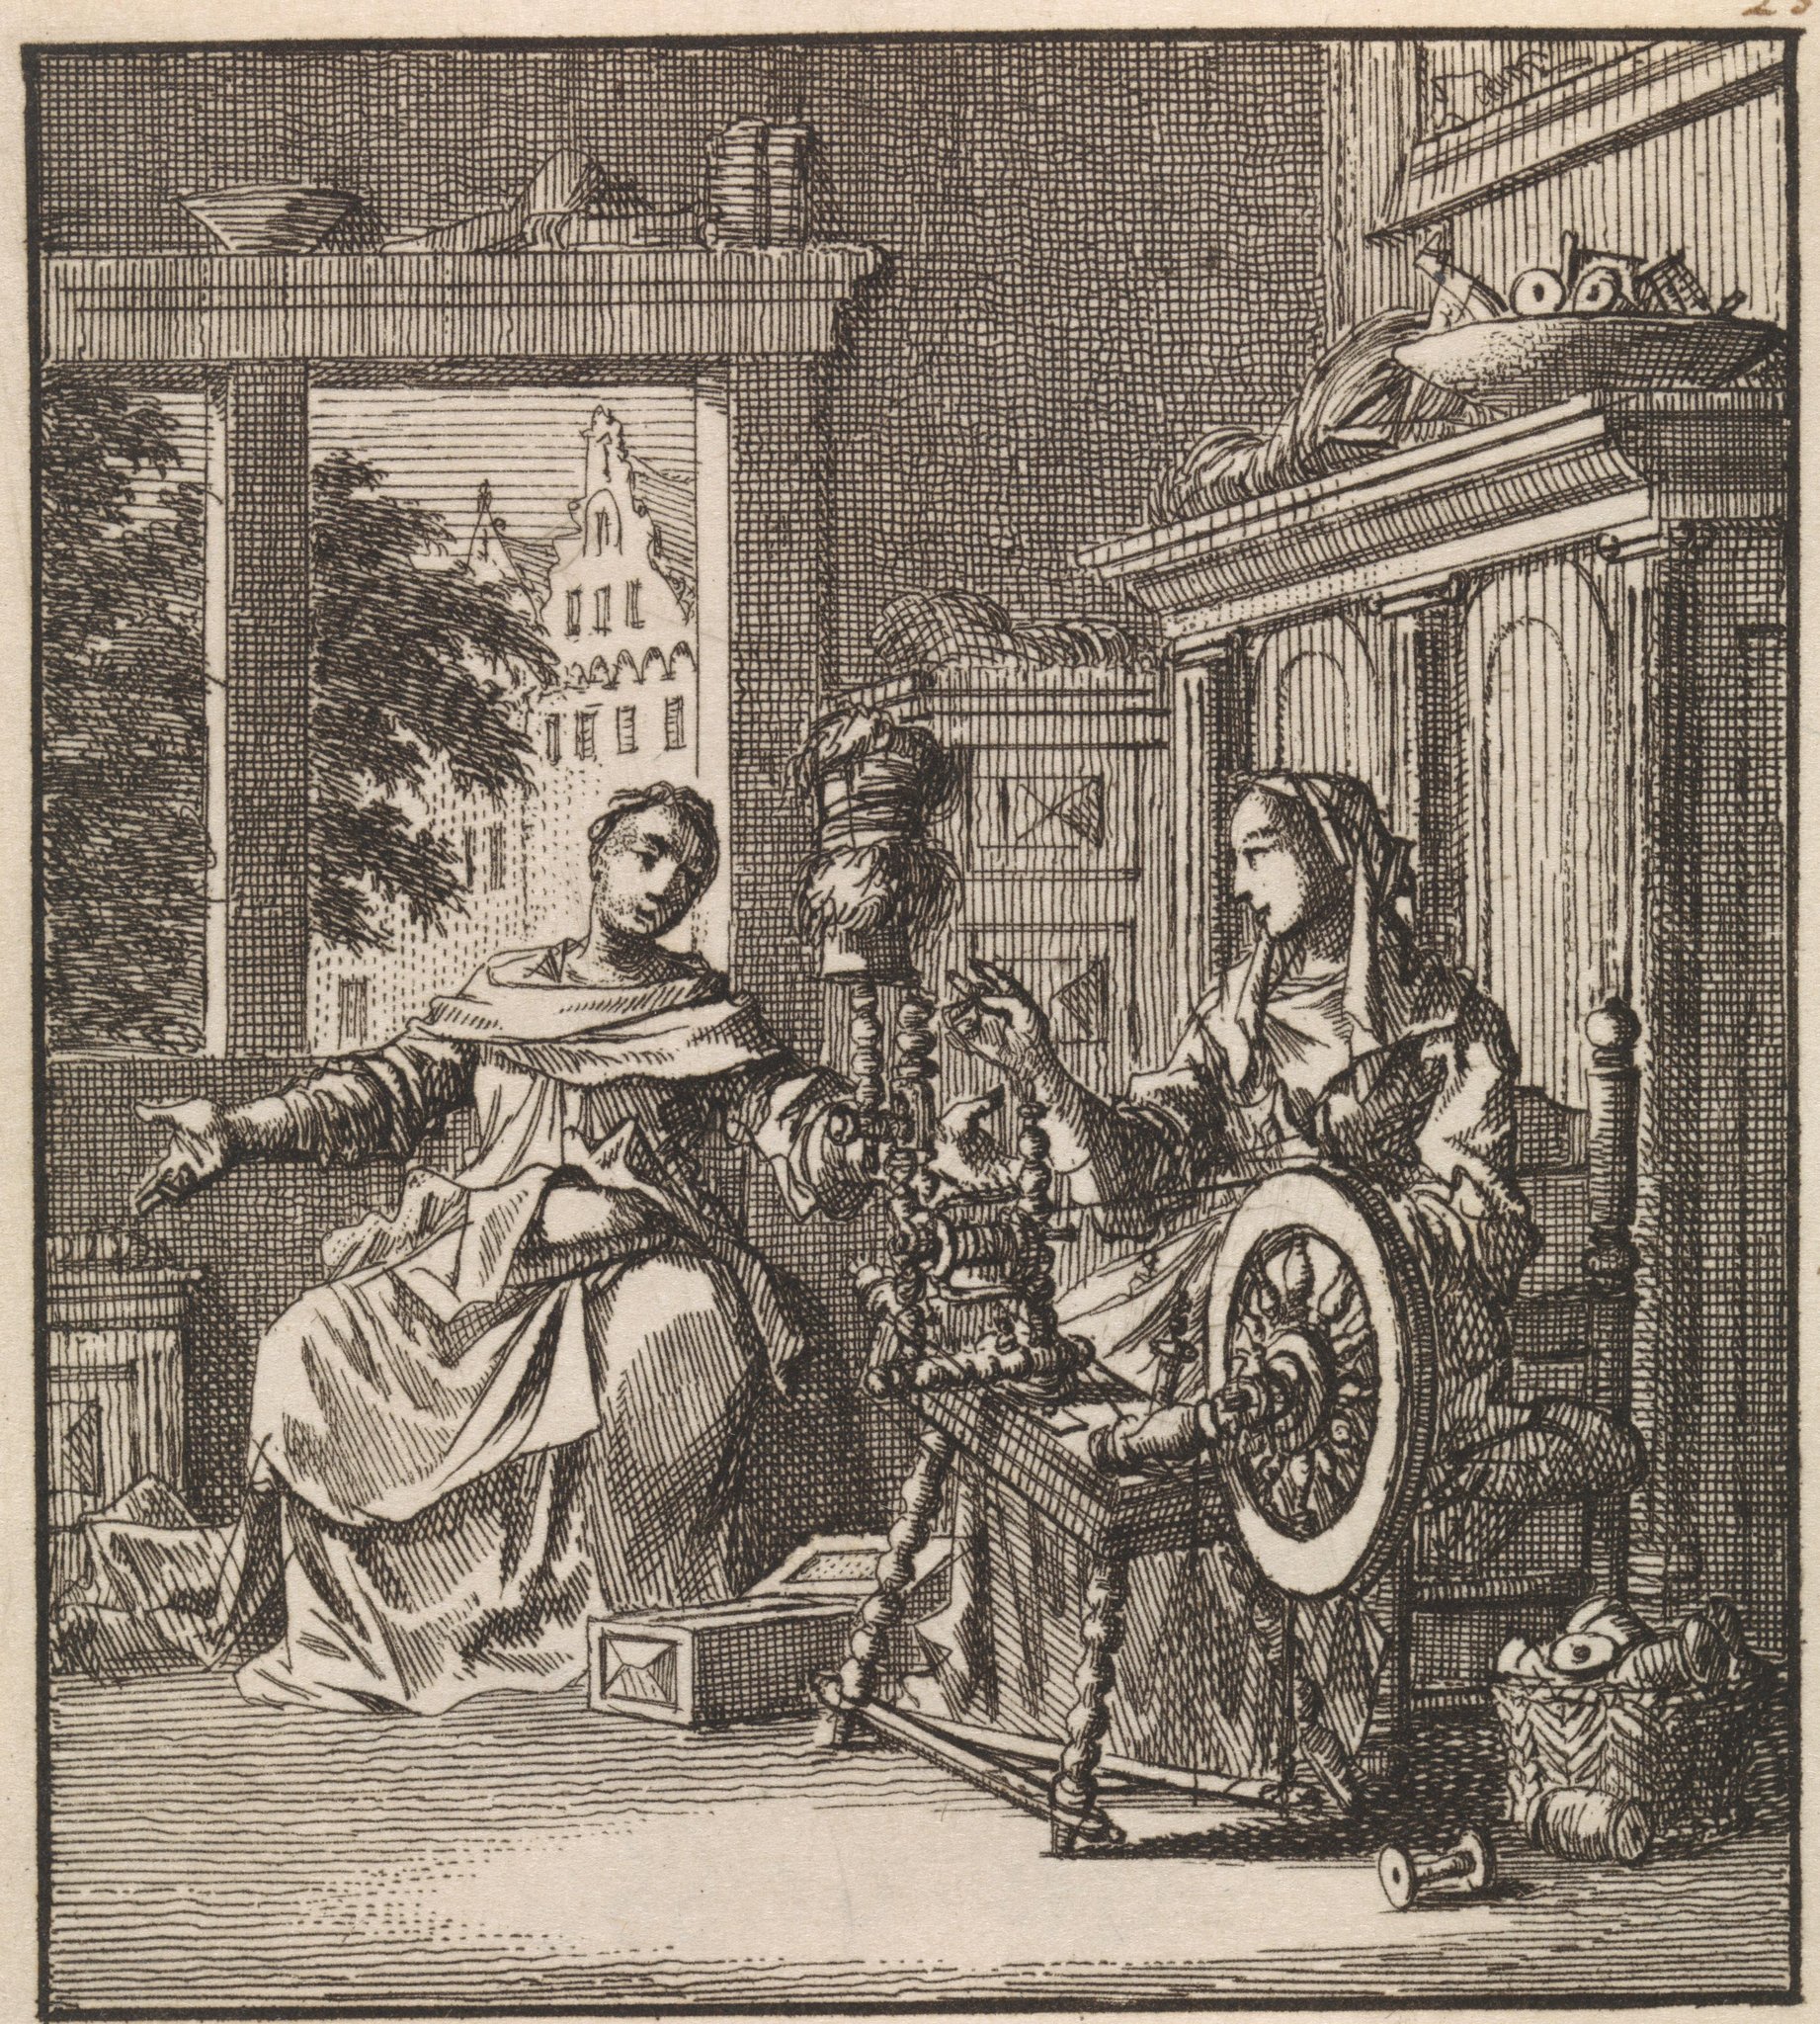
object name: print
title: Vrouw spint een draad en voert een gesprek met een andere vrouw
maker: jan luyken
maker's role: draughtsman, print maker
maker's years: 1649-1712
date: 1711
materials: paper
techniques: etching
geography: amsterdam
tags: spinning-wheel, conversation, dialogue; conversation piece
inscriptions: collector's mark: Lugt 2228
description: Proefdruk van illustratie voor: Luyken, Jan. Het leerzaam huisraad, vertoond in vyftig konstige figuuren, met godlyke spreuken en stichtelyke verzen: Pieter Arentsz. II (wed.) en Cornelis van der Sys, 1711, p. 80.